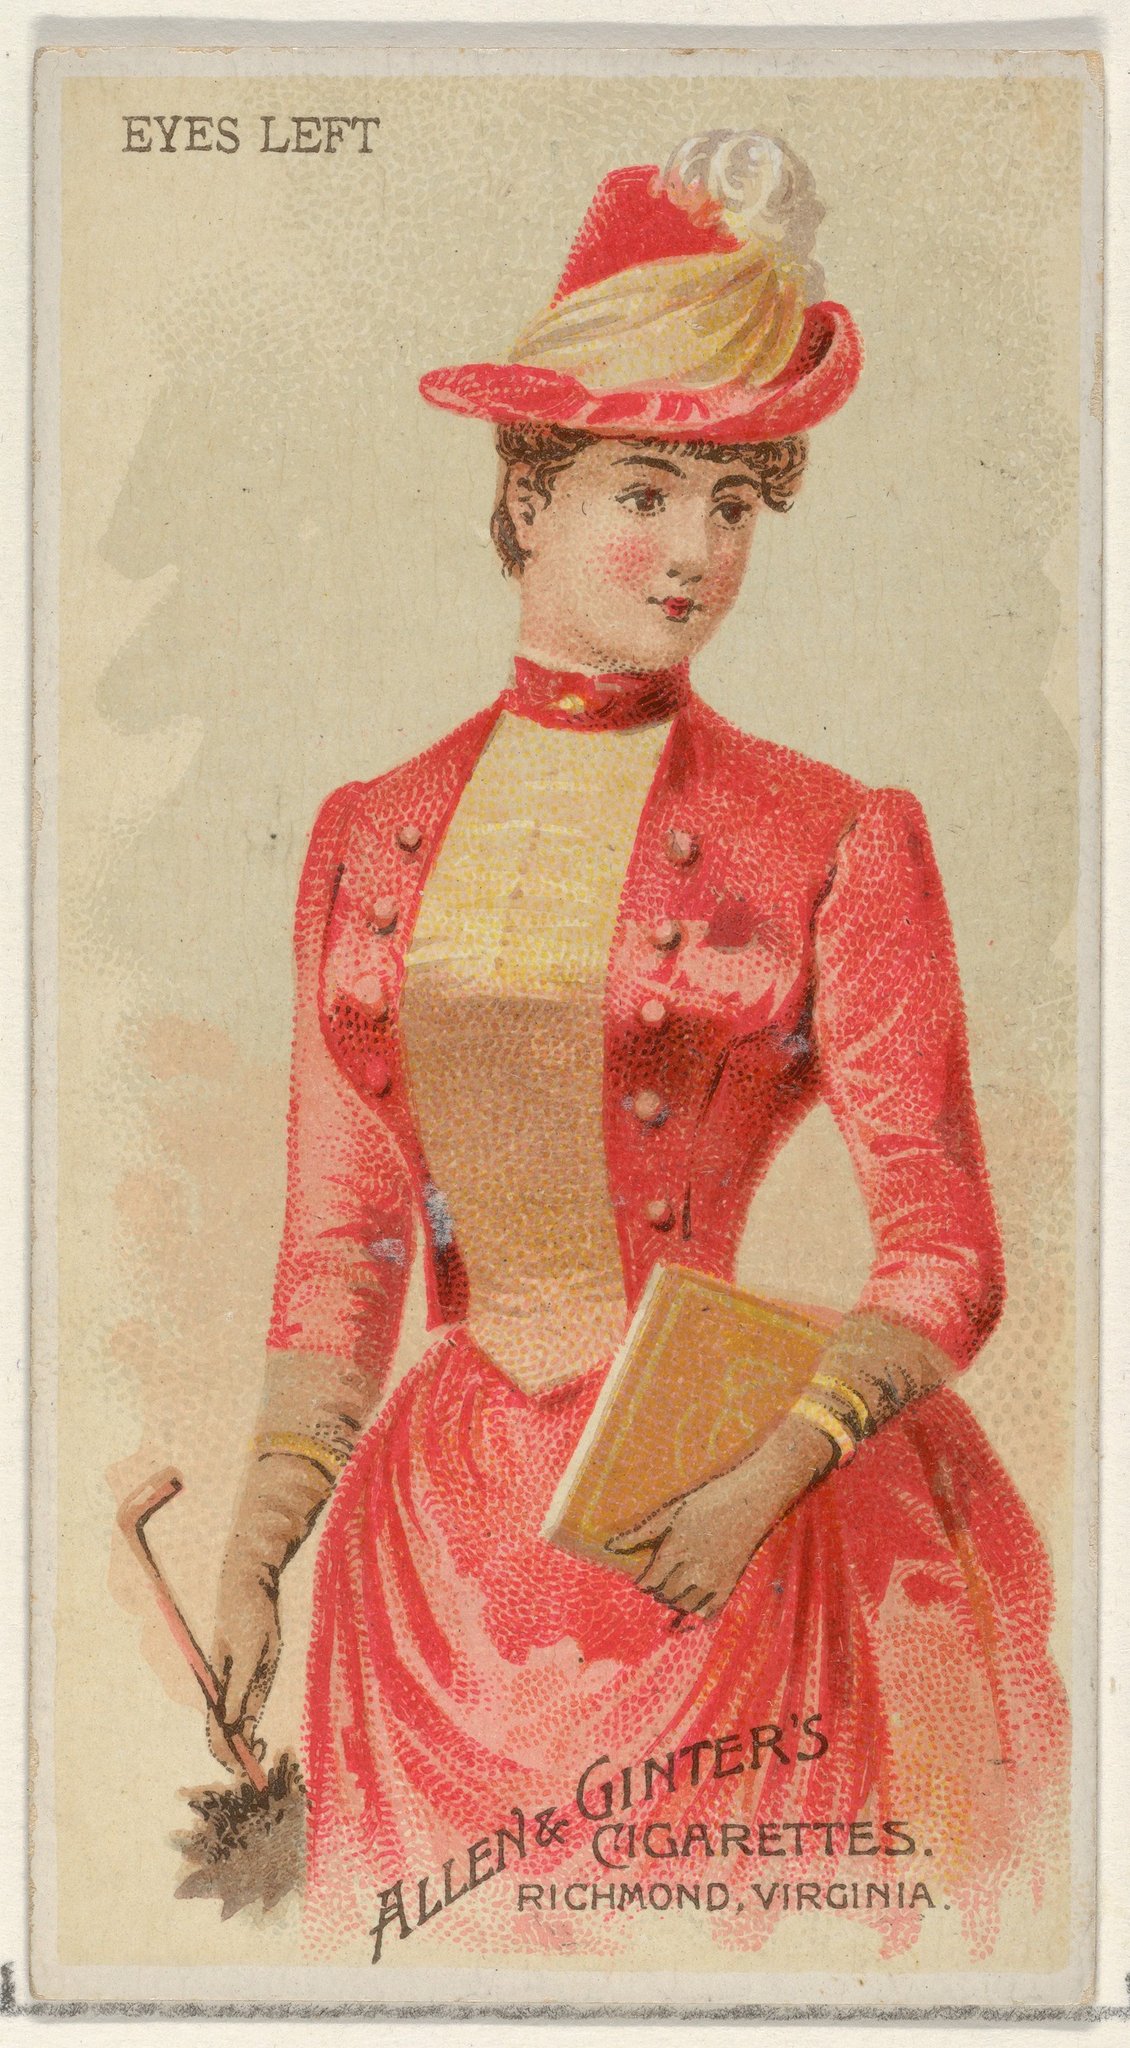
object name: print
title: Eyes Left, from the Parasol Drills series (N18) for Allen & Ginter Cigarettes Brands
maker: allen & ginter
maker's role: publisher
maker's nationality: american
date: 1888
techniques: color lithograph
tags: women